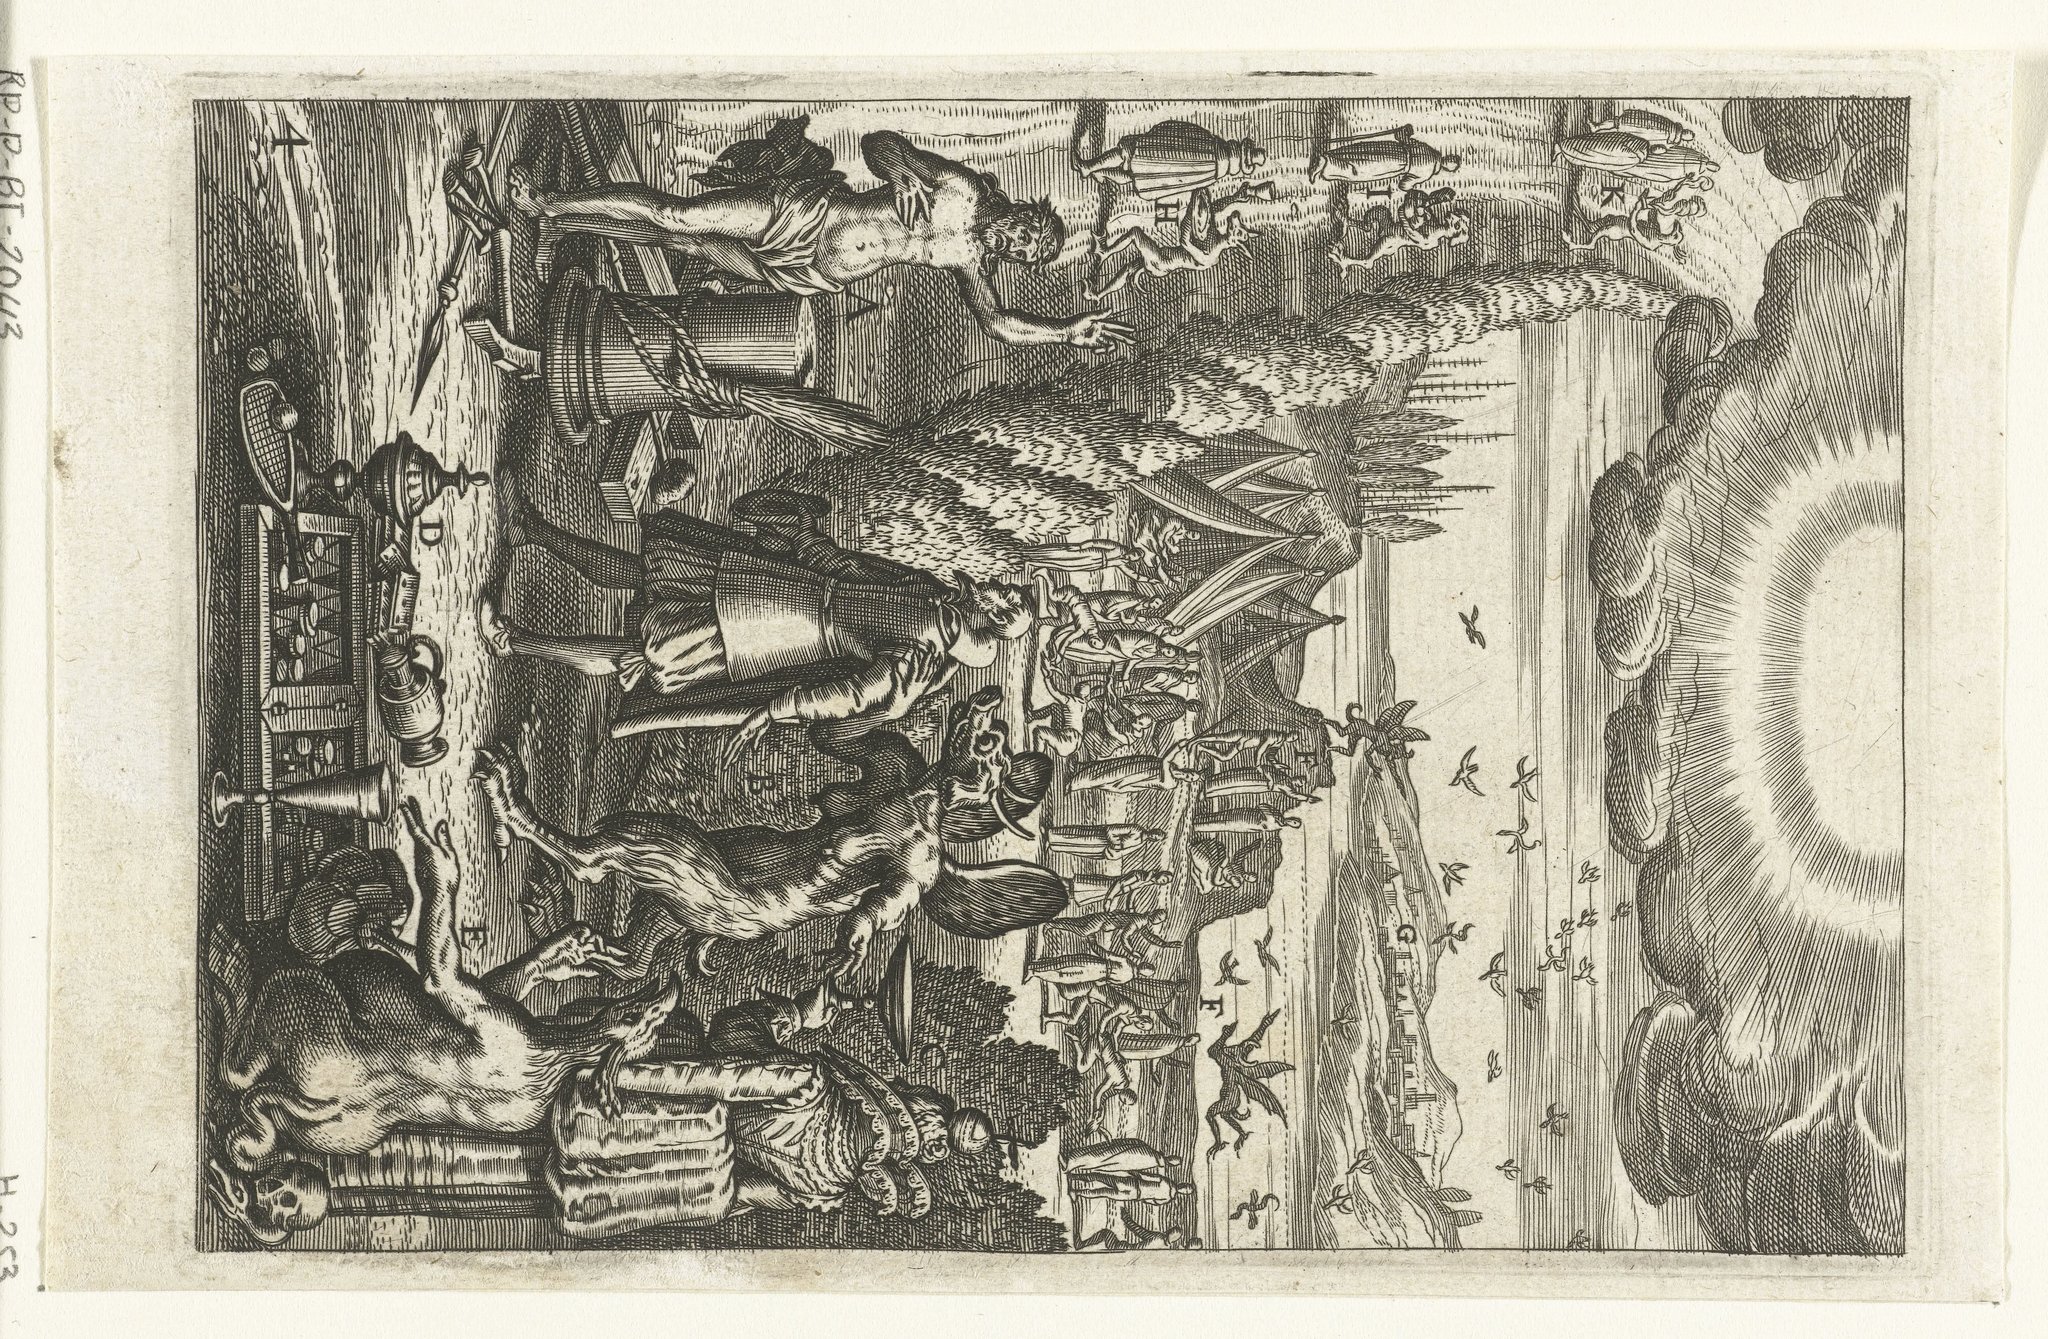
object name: book illustration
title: Embleem met man op de weg naar het eeuwige leven die wordt blootgesteld aan verzoekingen van de duivel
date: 1620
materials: paper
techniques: engraving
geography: low countries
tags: man between good and evil, (personifications of) 'vanitas', the vanity of human life; fragilità humana, fugacità delle grandezze & della gloria mondana, meditatione della morte, opera vana, piacere vano, vana gloria, vanità (ripa), 'vanitas' symbols, the christian knight, 'miles christianus', vice, evil, sin; 'peccato' (ripa), human-shaped devil, journey to heaven, pathway to heaven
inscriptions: collector's mark: Lugt 2228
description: Een man op de weg naar het eeuwige leven ontmoet Christus met de passiewerktuigen. Op zijn weg wordt de man in verzoeking gebracht door de duivel die hem confronteert met zijn verworpen aardse bezittingen.